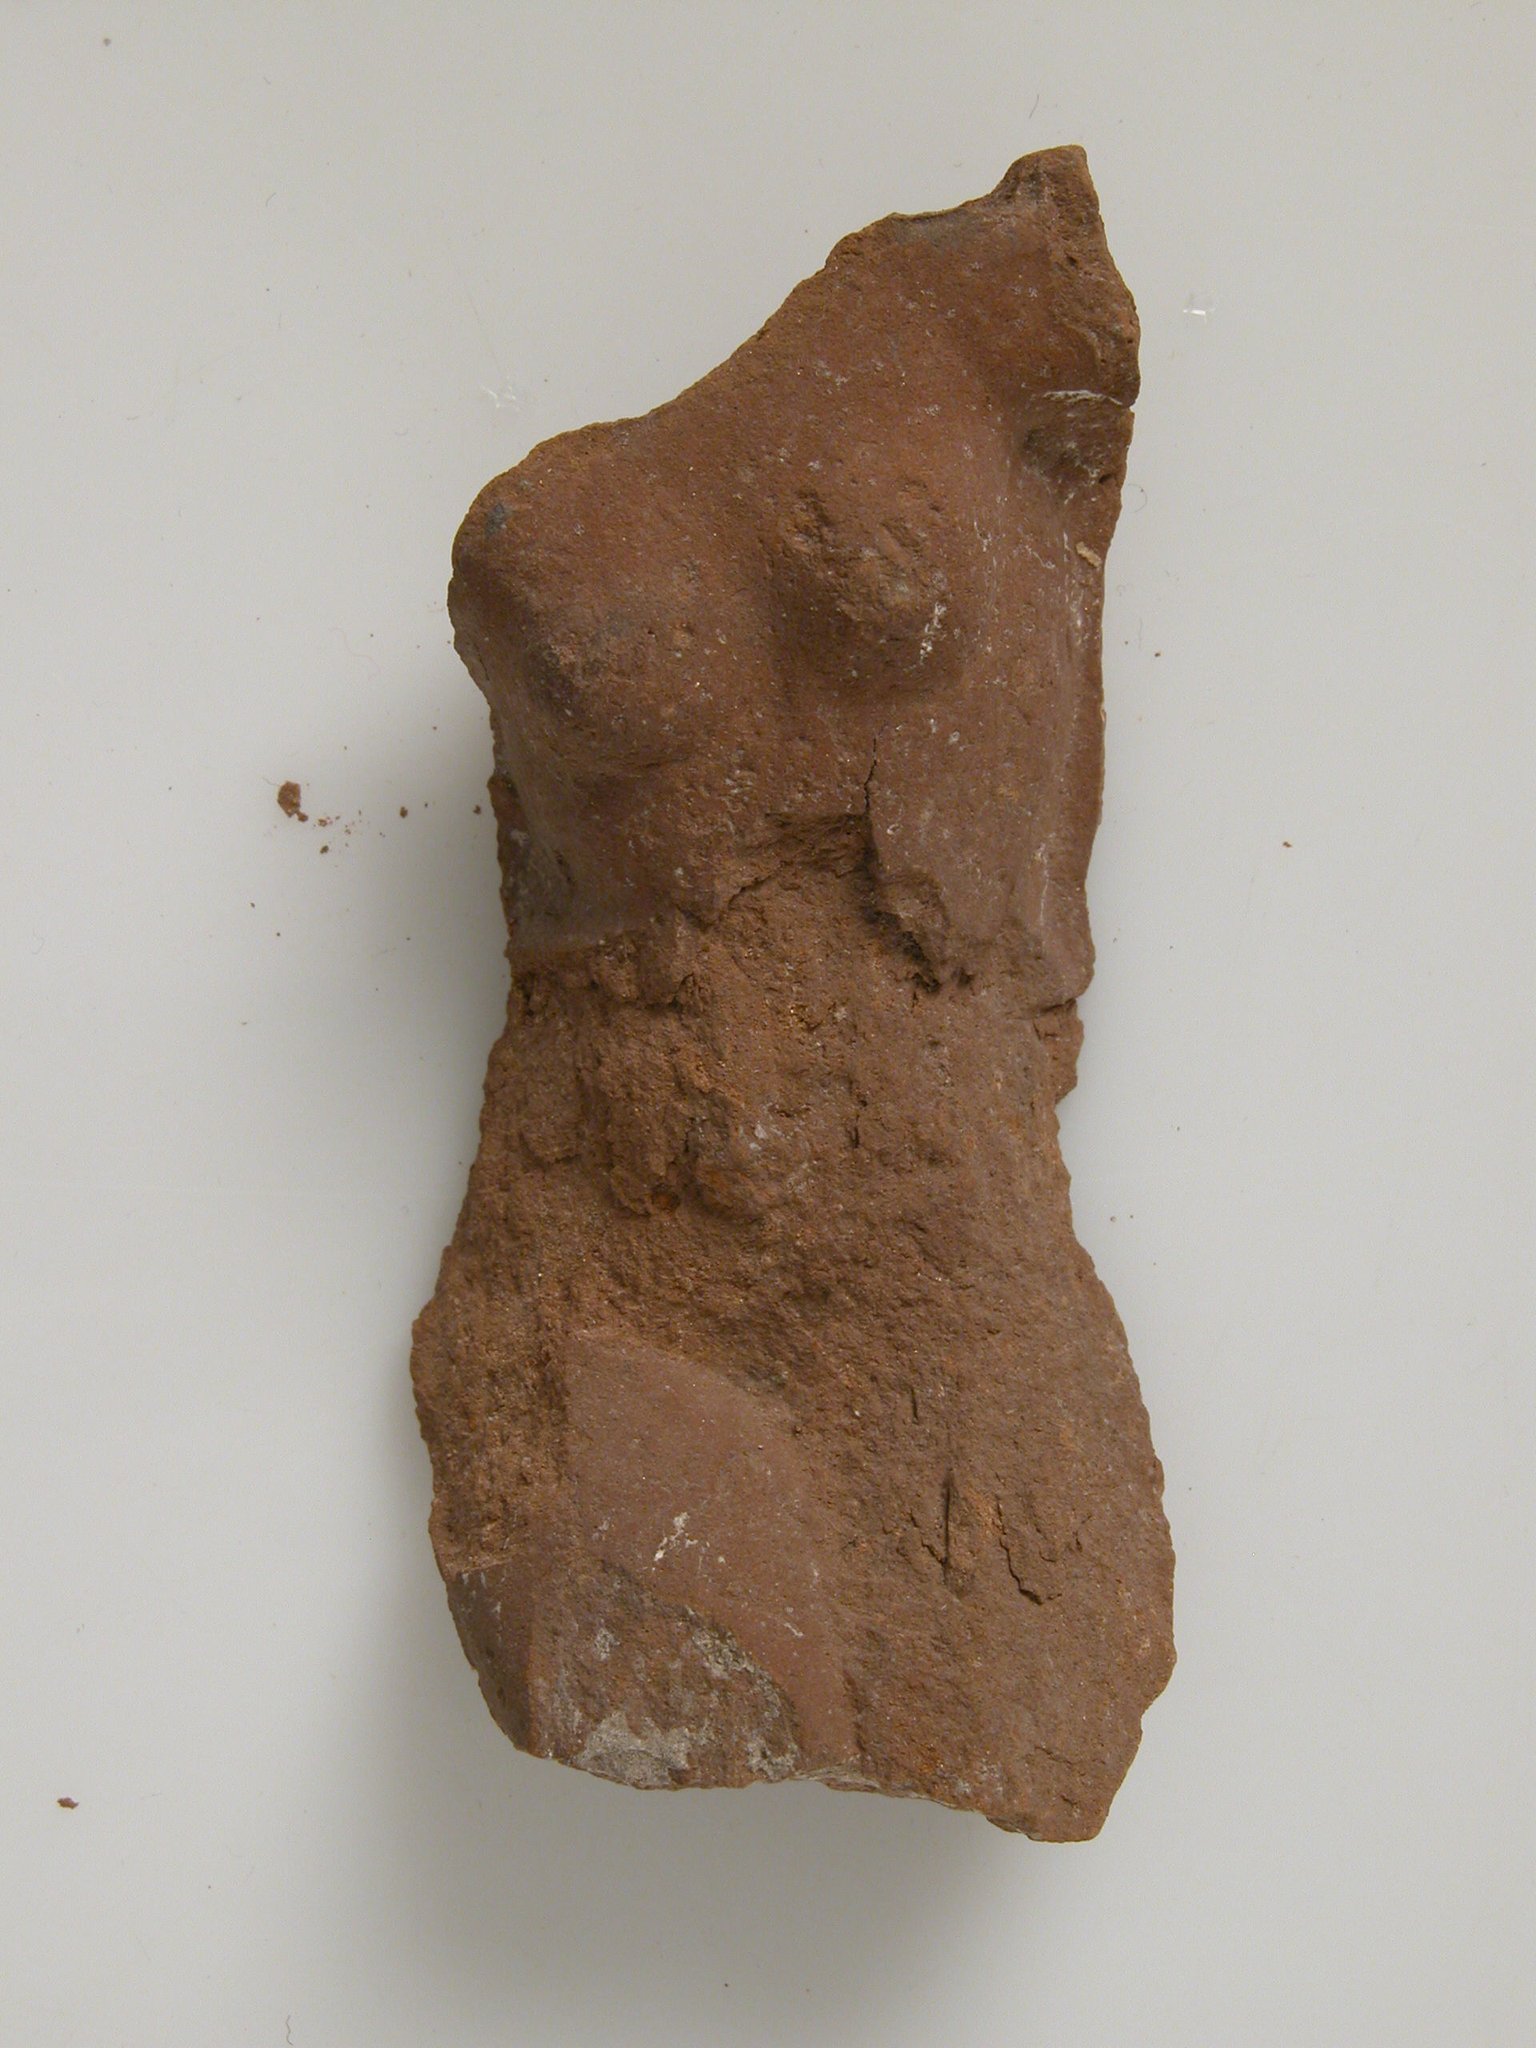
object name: statuette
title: Fragment of a Female Figure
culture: coptic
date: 301-700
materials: earthenware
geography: egypt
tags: female nudes